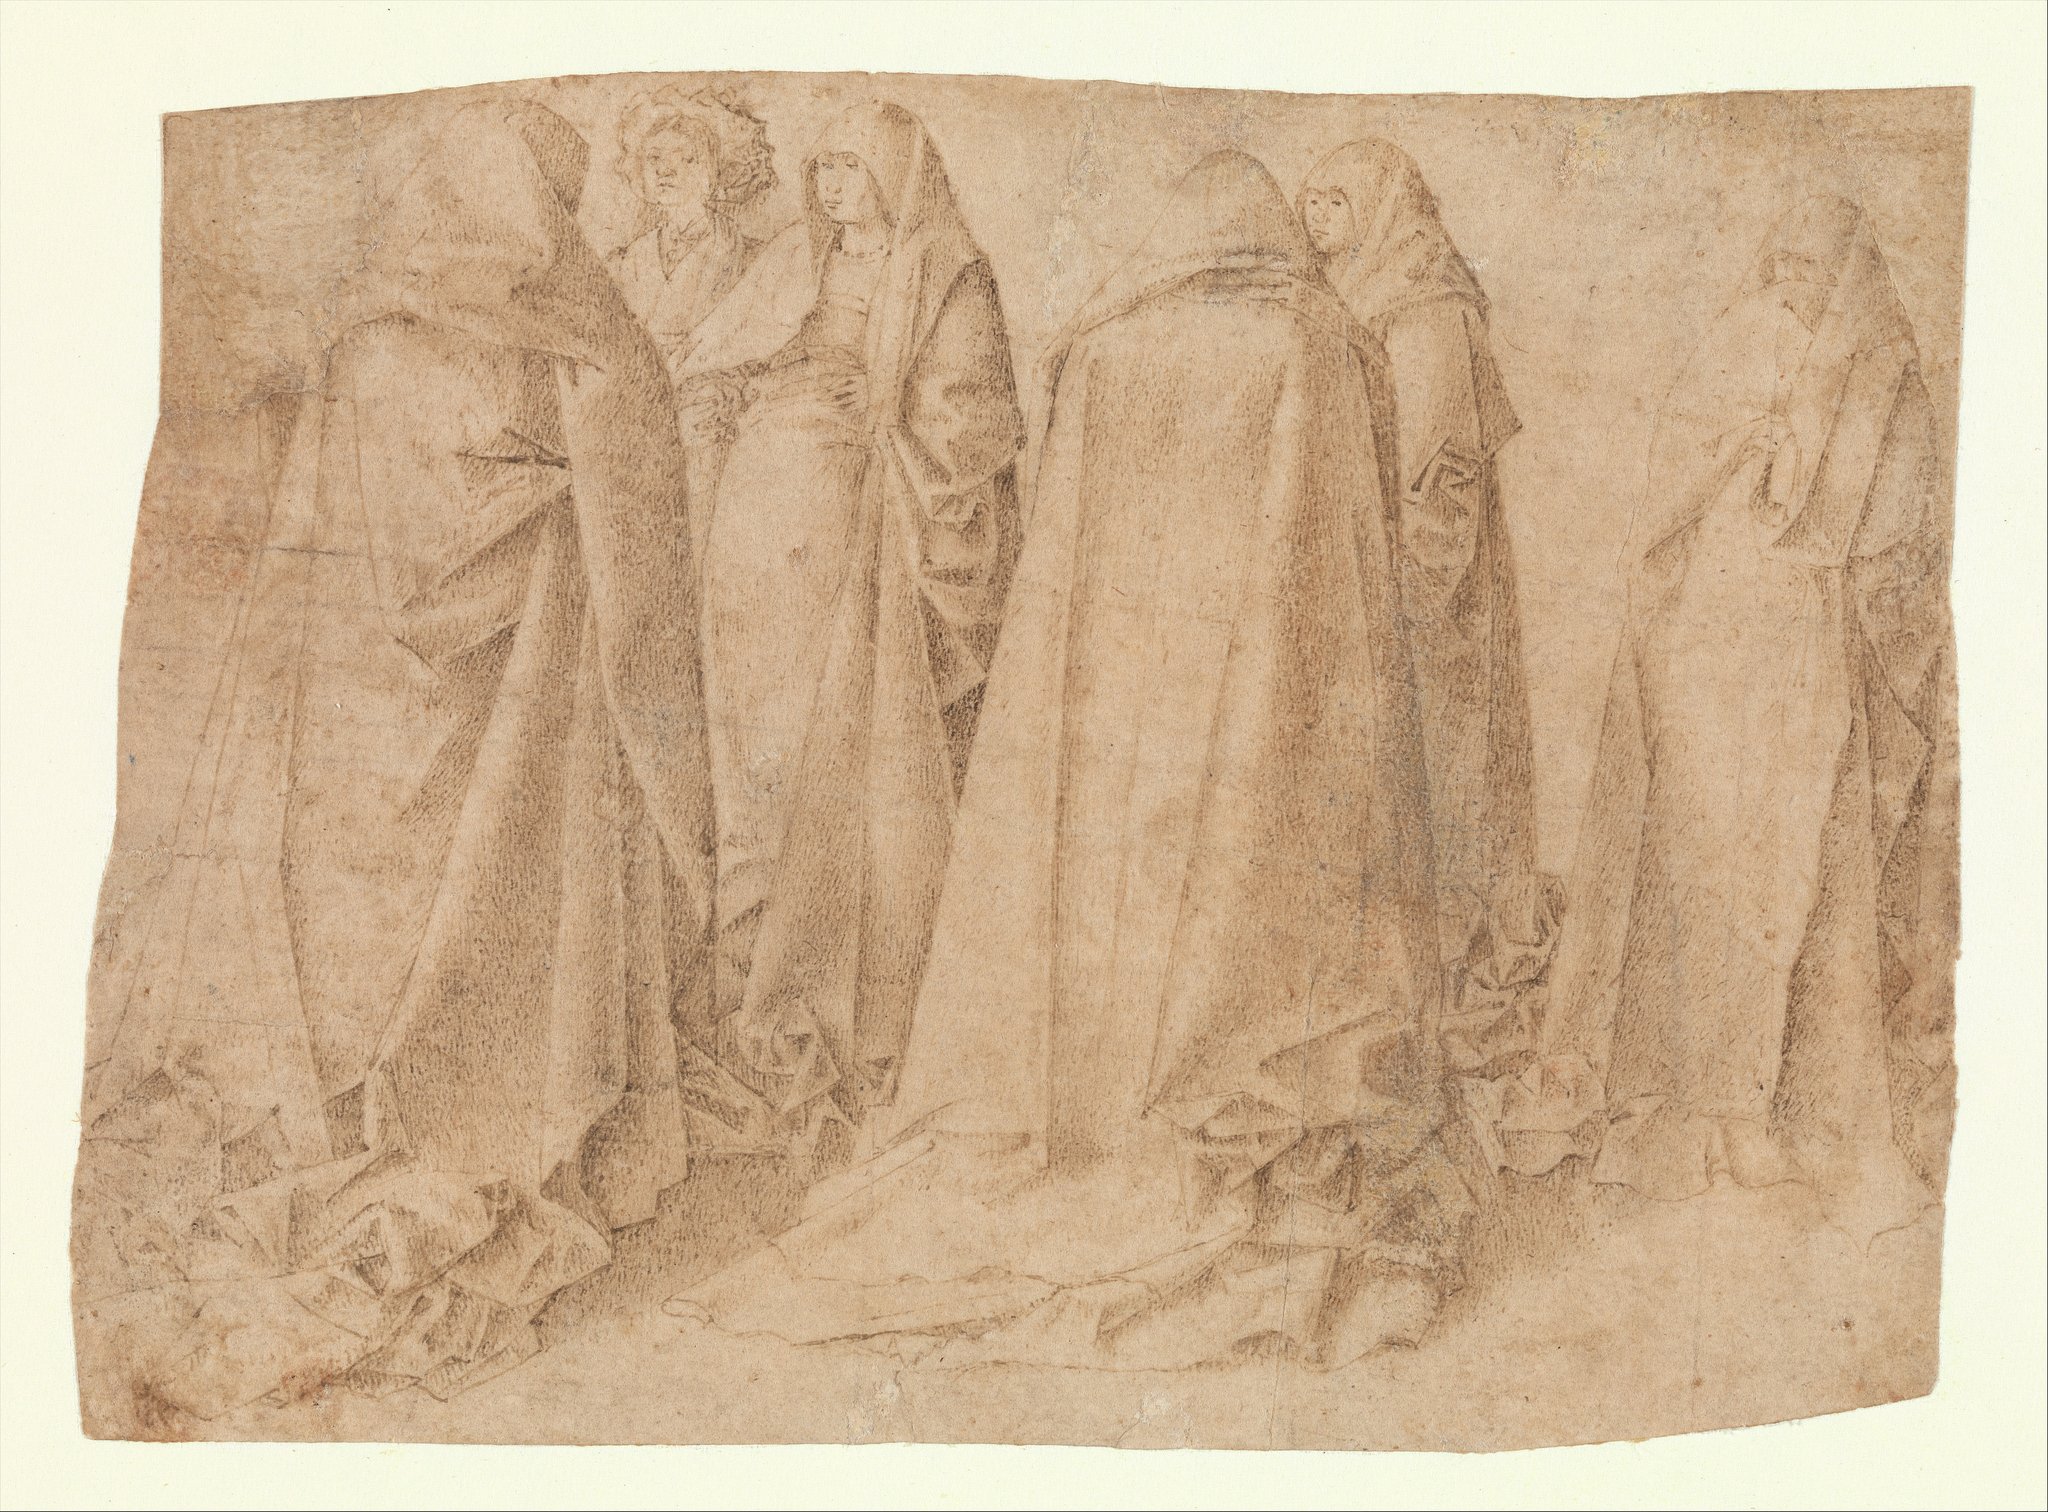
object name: drawing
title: Group of Draped Figures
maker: antonello da messina (antonello di giovanni d'antonio)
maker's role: artist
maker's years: 1430-1479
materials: ink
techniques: brush, pen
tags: women